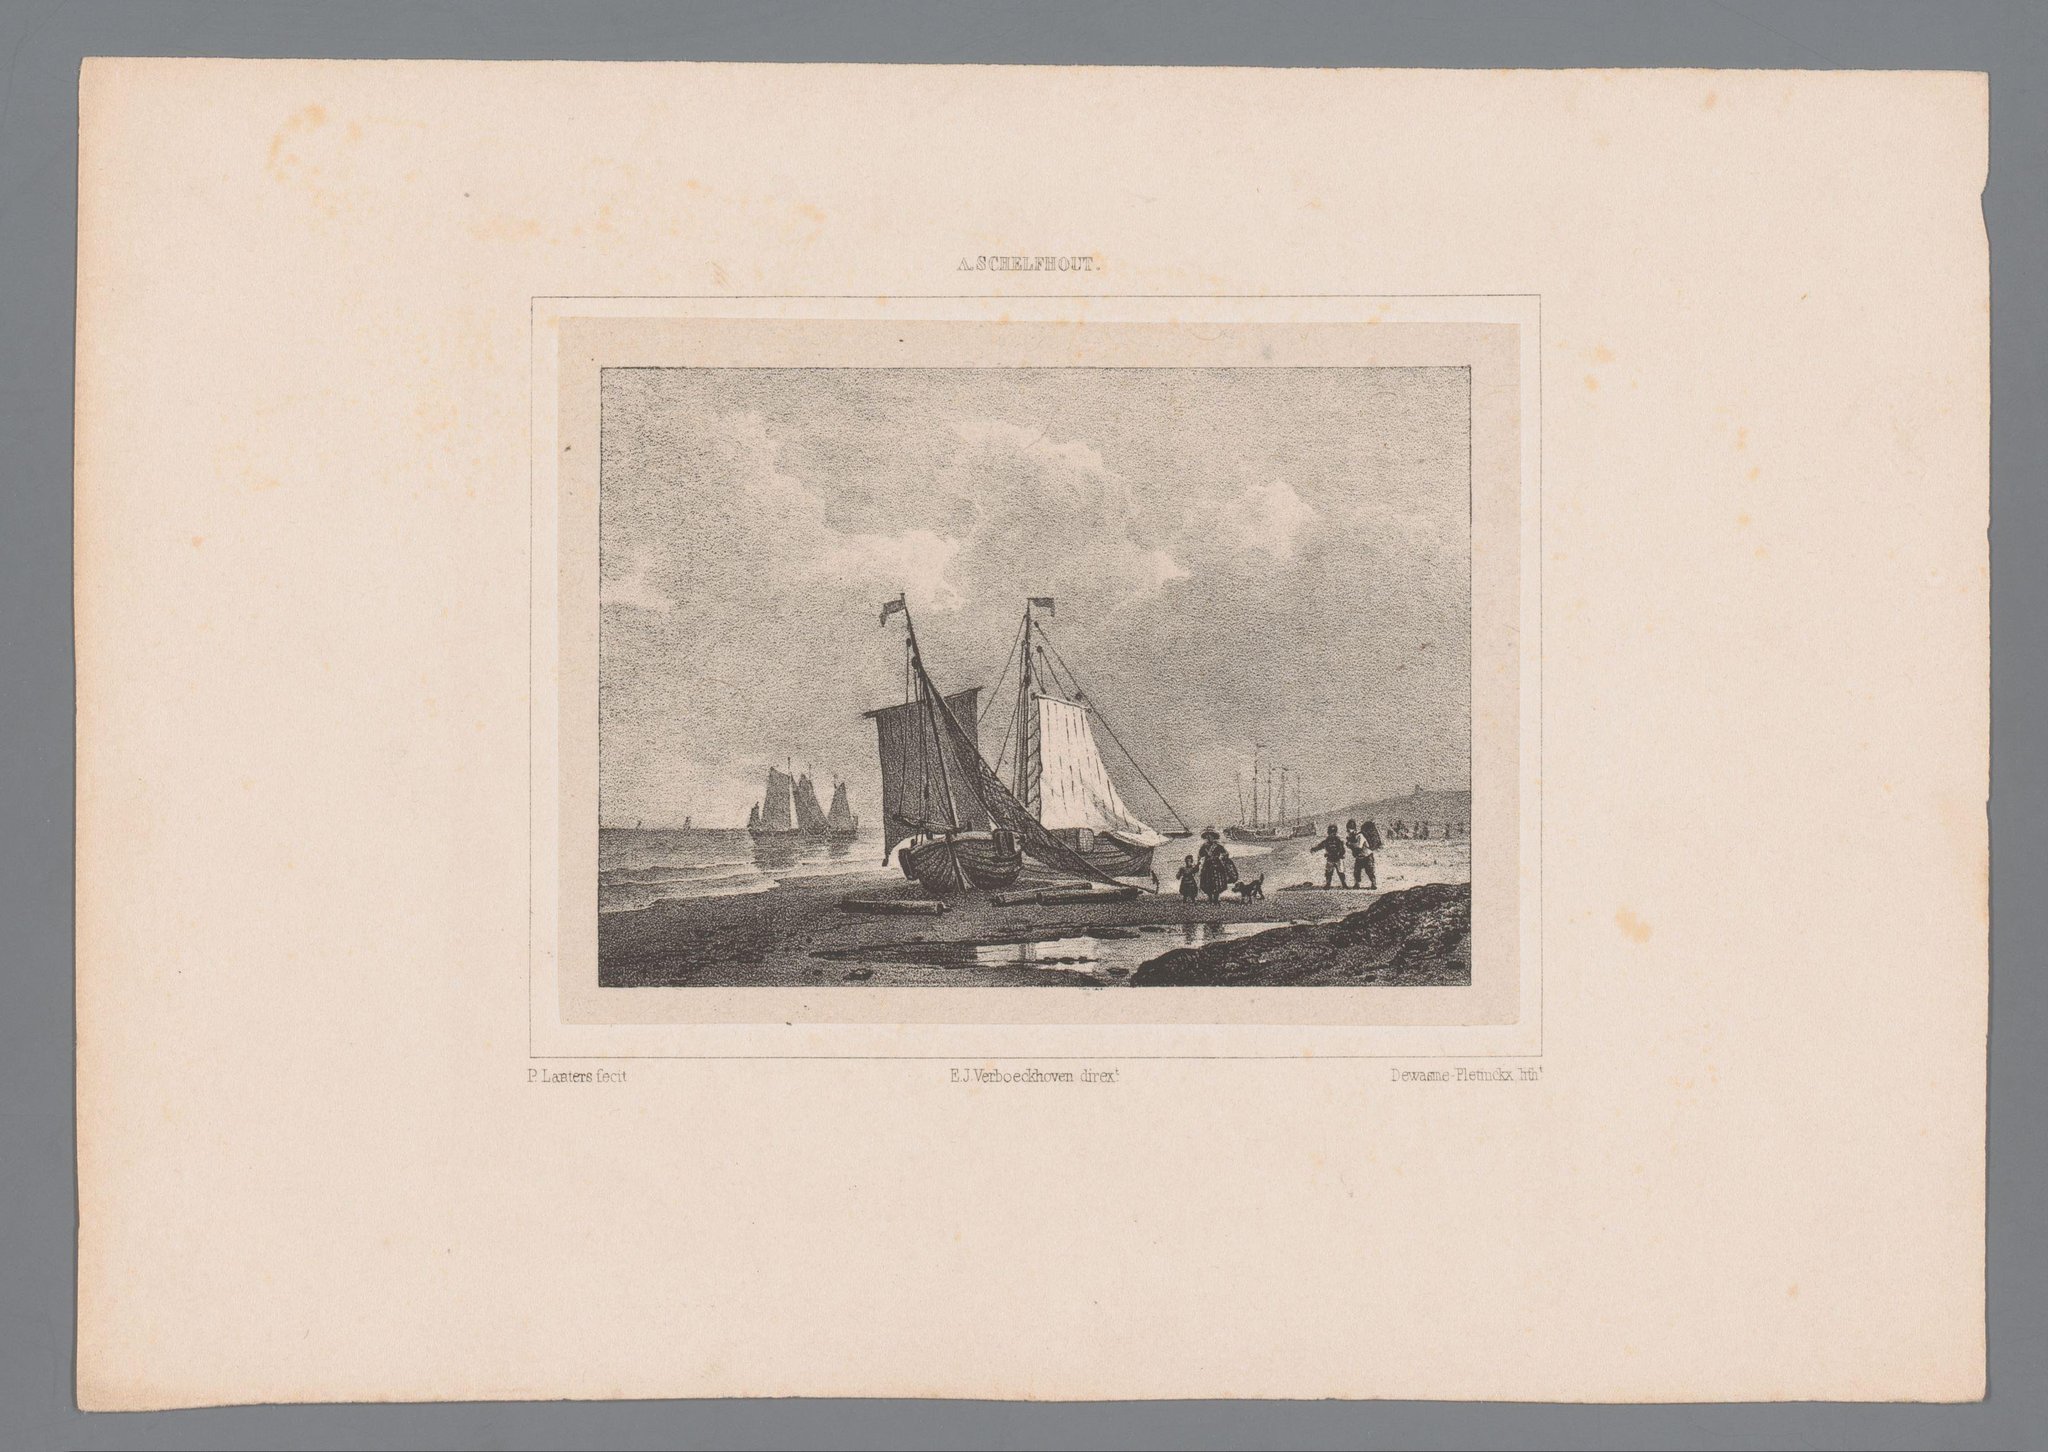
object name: print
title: A. Schelfhout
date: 1829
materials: paper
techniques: lithograph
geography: brussels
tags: sea (seascape), ships (in general) - cc - more than one ship, coast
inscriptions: collector's mark: Lugt 2228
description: Prent verschenen in: Verboeckhoven, Eugène. Album lithographié par Paul Lauters d'après les dessins des principaux peintres du Royaume des Pays-Bas. Brussel: Antoine Dewasme-Pletinckx, 1829.